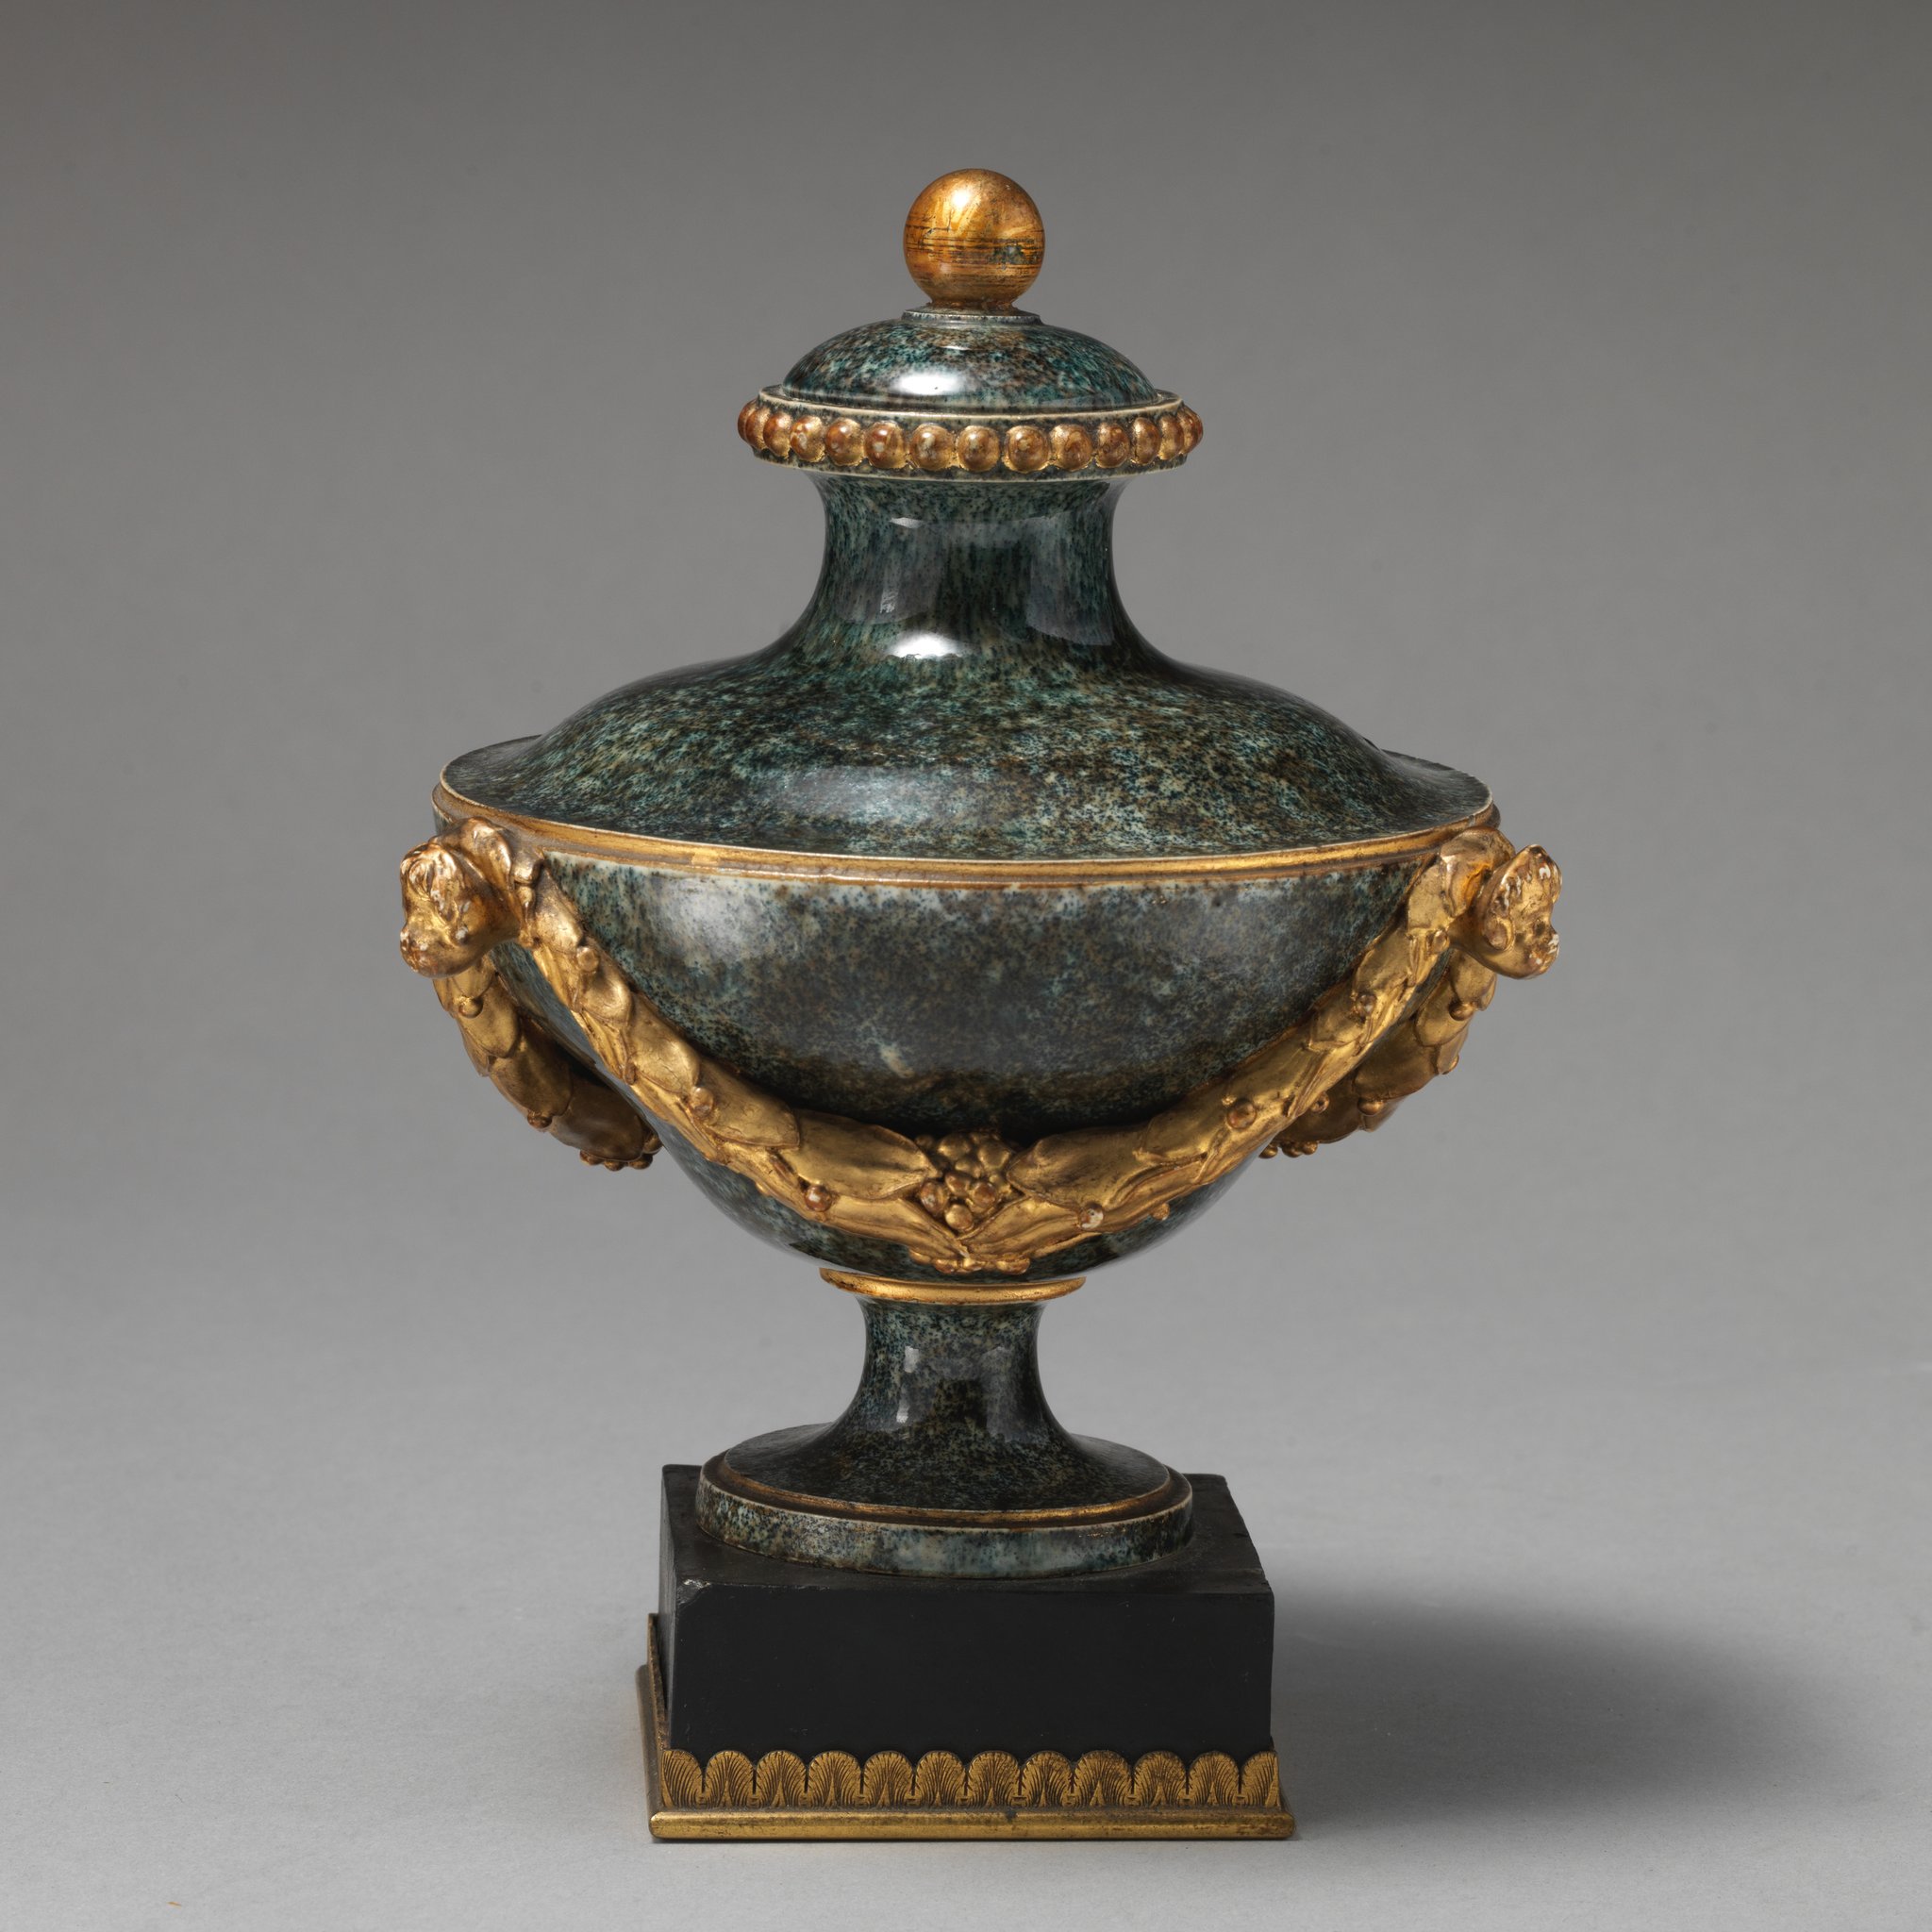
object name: vase with cover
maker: wedgwood and bentley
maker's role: factory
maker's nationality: british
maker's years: 1769-1780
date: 1769-1780